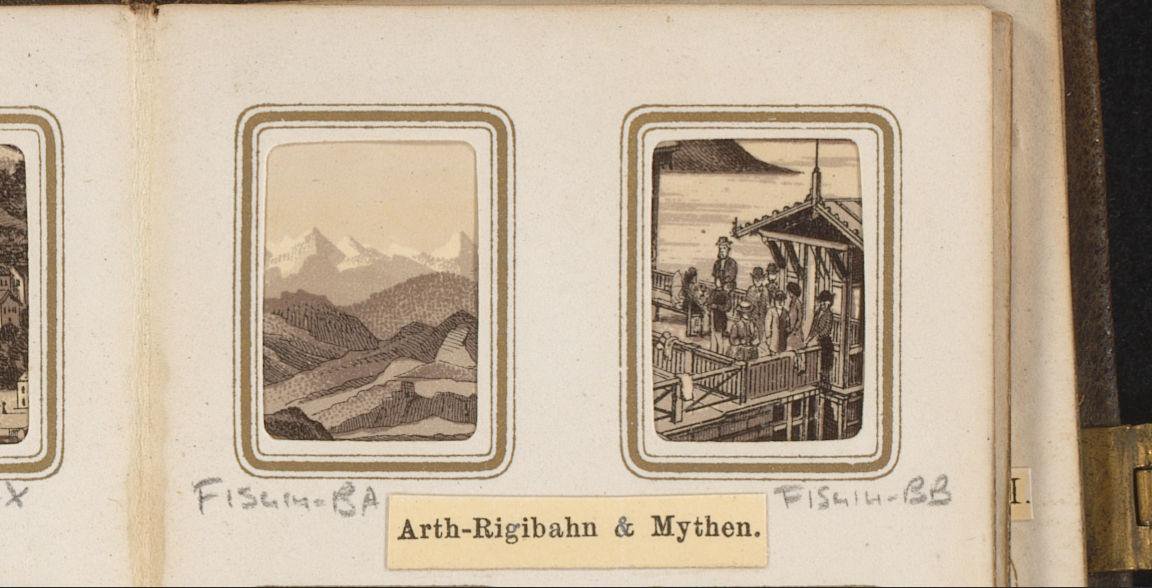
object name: album leaf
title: Gezicht vanaf Mythen in de Schwyzer Alpen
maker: Anonymous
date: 1851-1910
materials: paper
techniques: lithograph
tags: mountains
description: Deze prent maakt deel uit van een album.